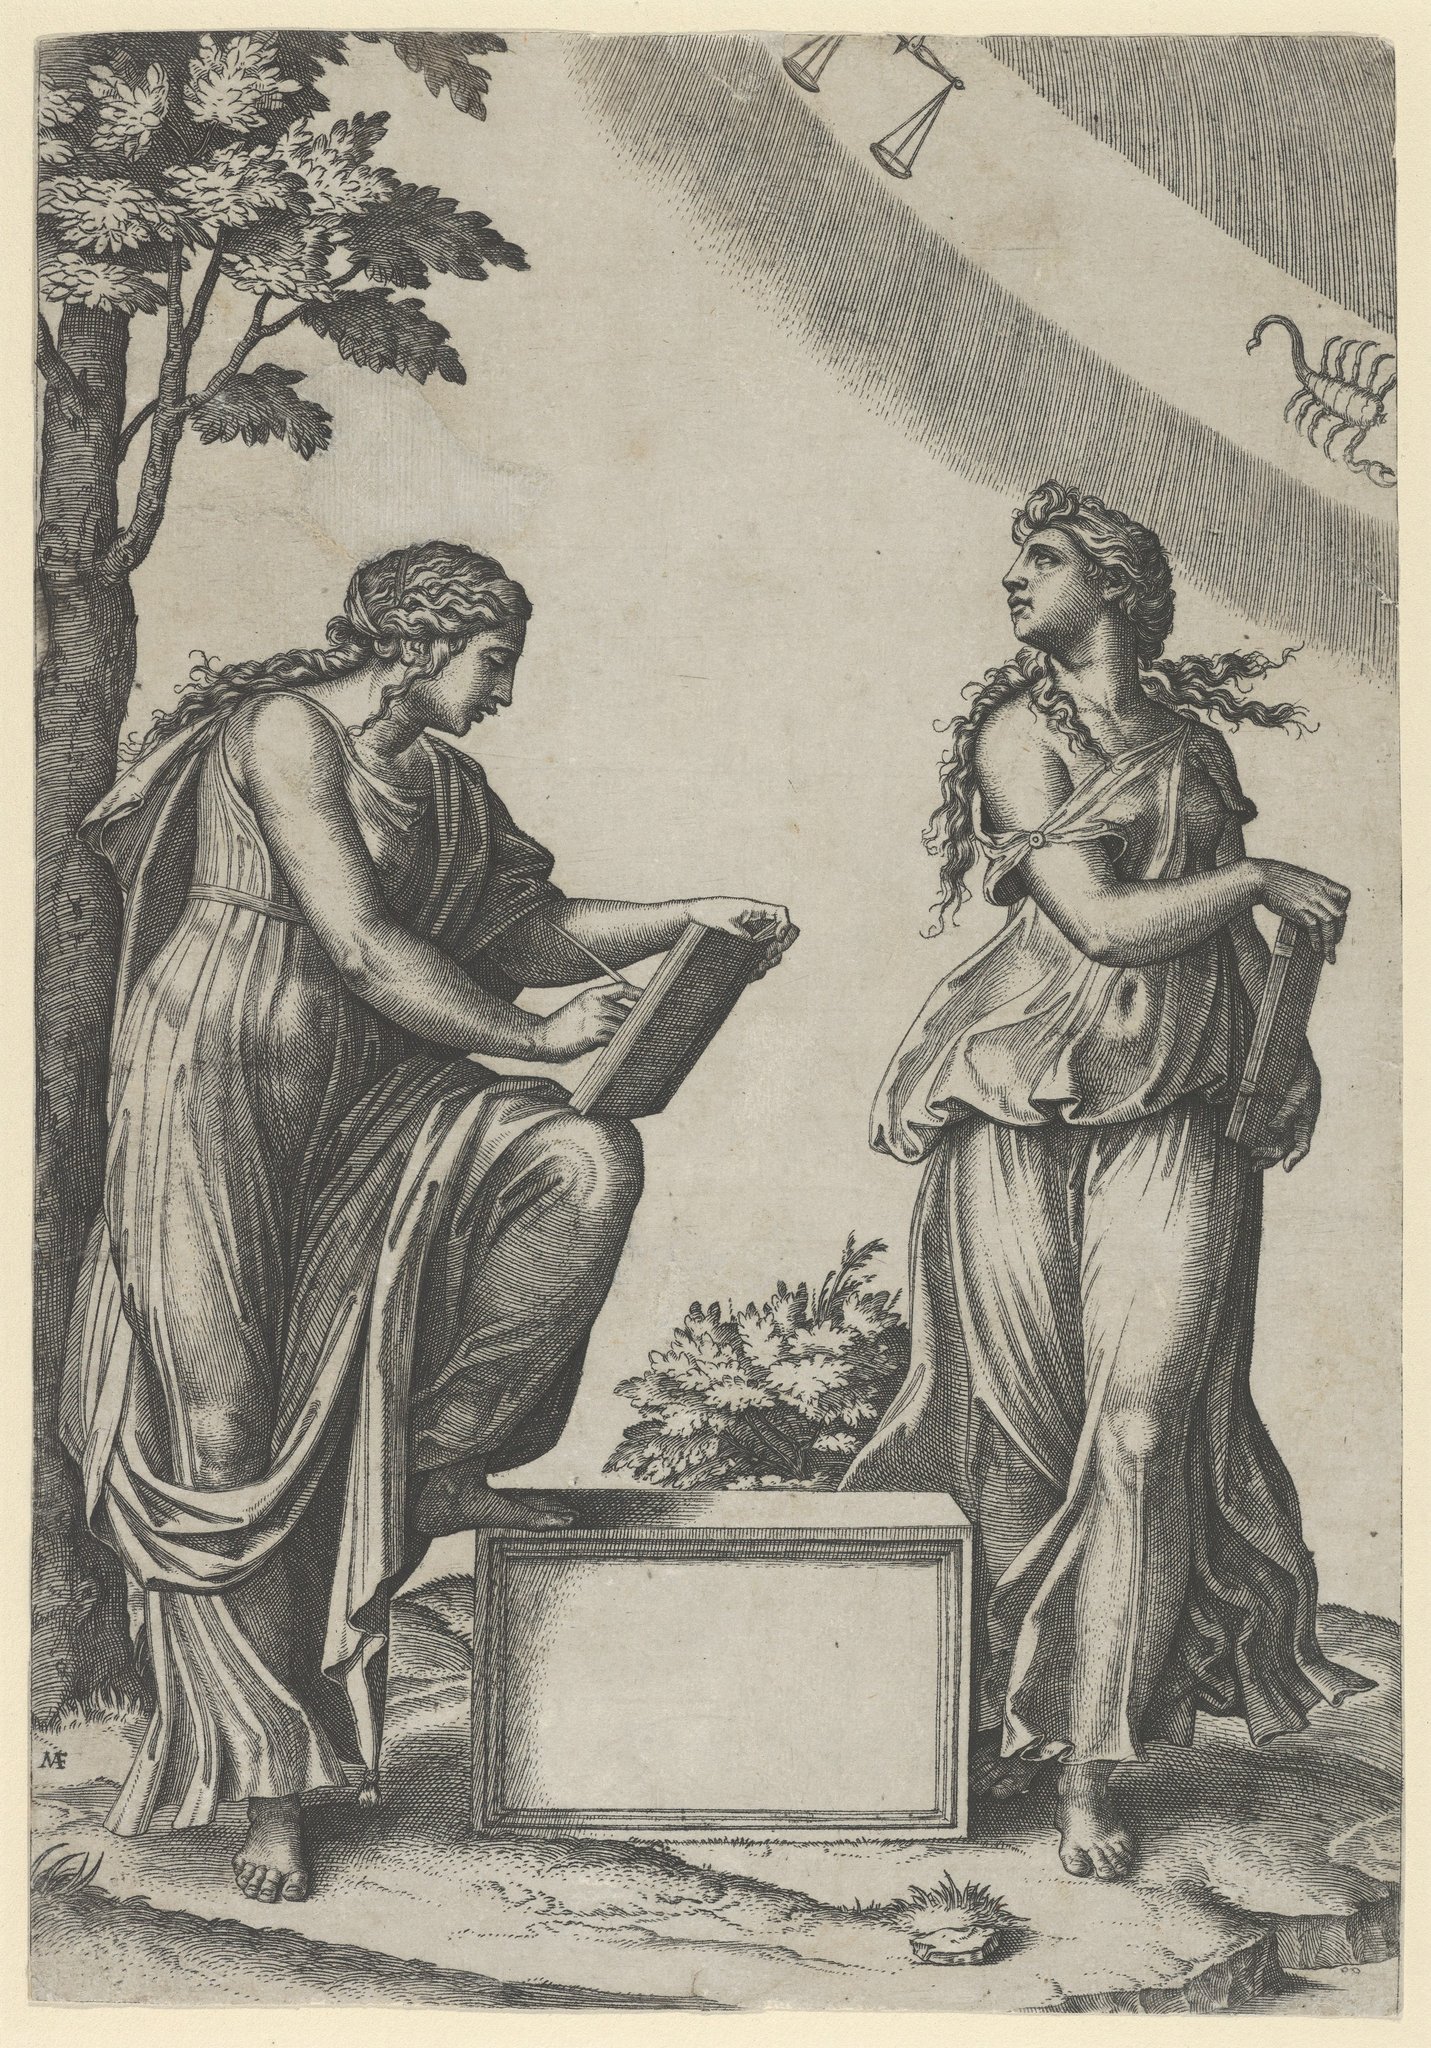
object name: print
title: Two women of the zodiac standing beneath the signs of Libra and Scorpio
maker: marcantonio raimondi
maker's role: artist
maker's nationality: italian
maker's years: 1475-1534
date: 1517-1520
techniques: engraving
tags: women,zodiac,writing